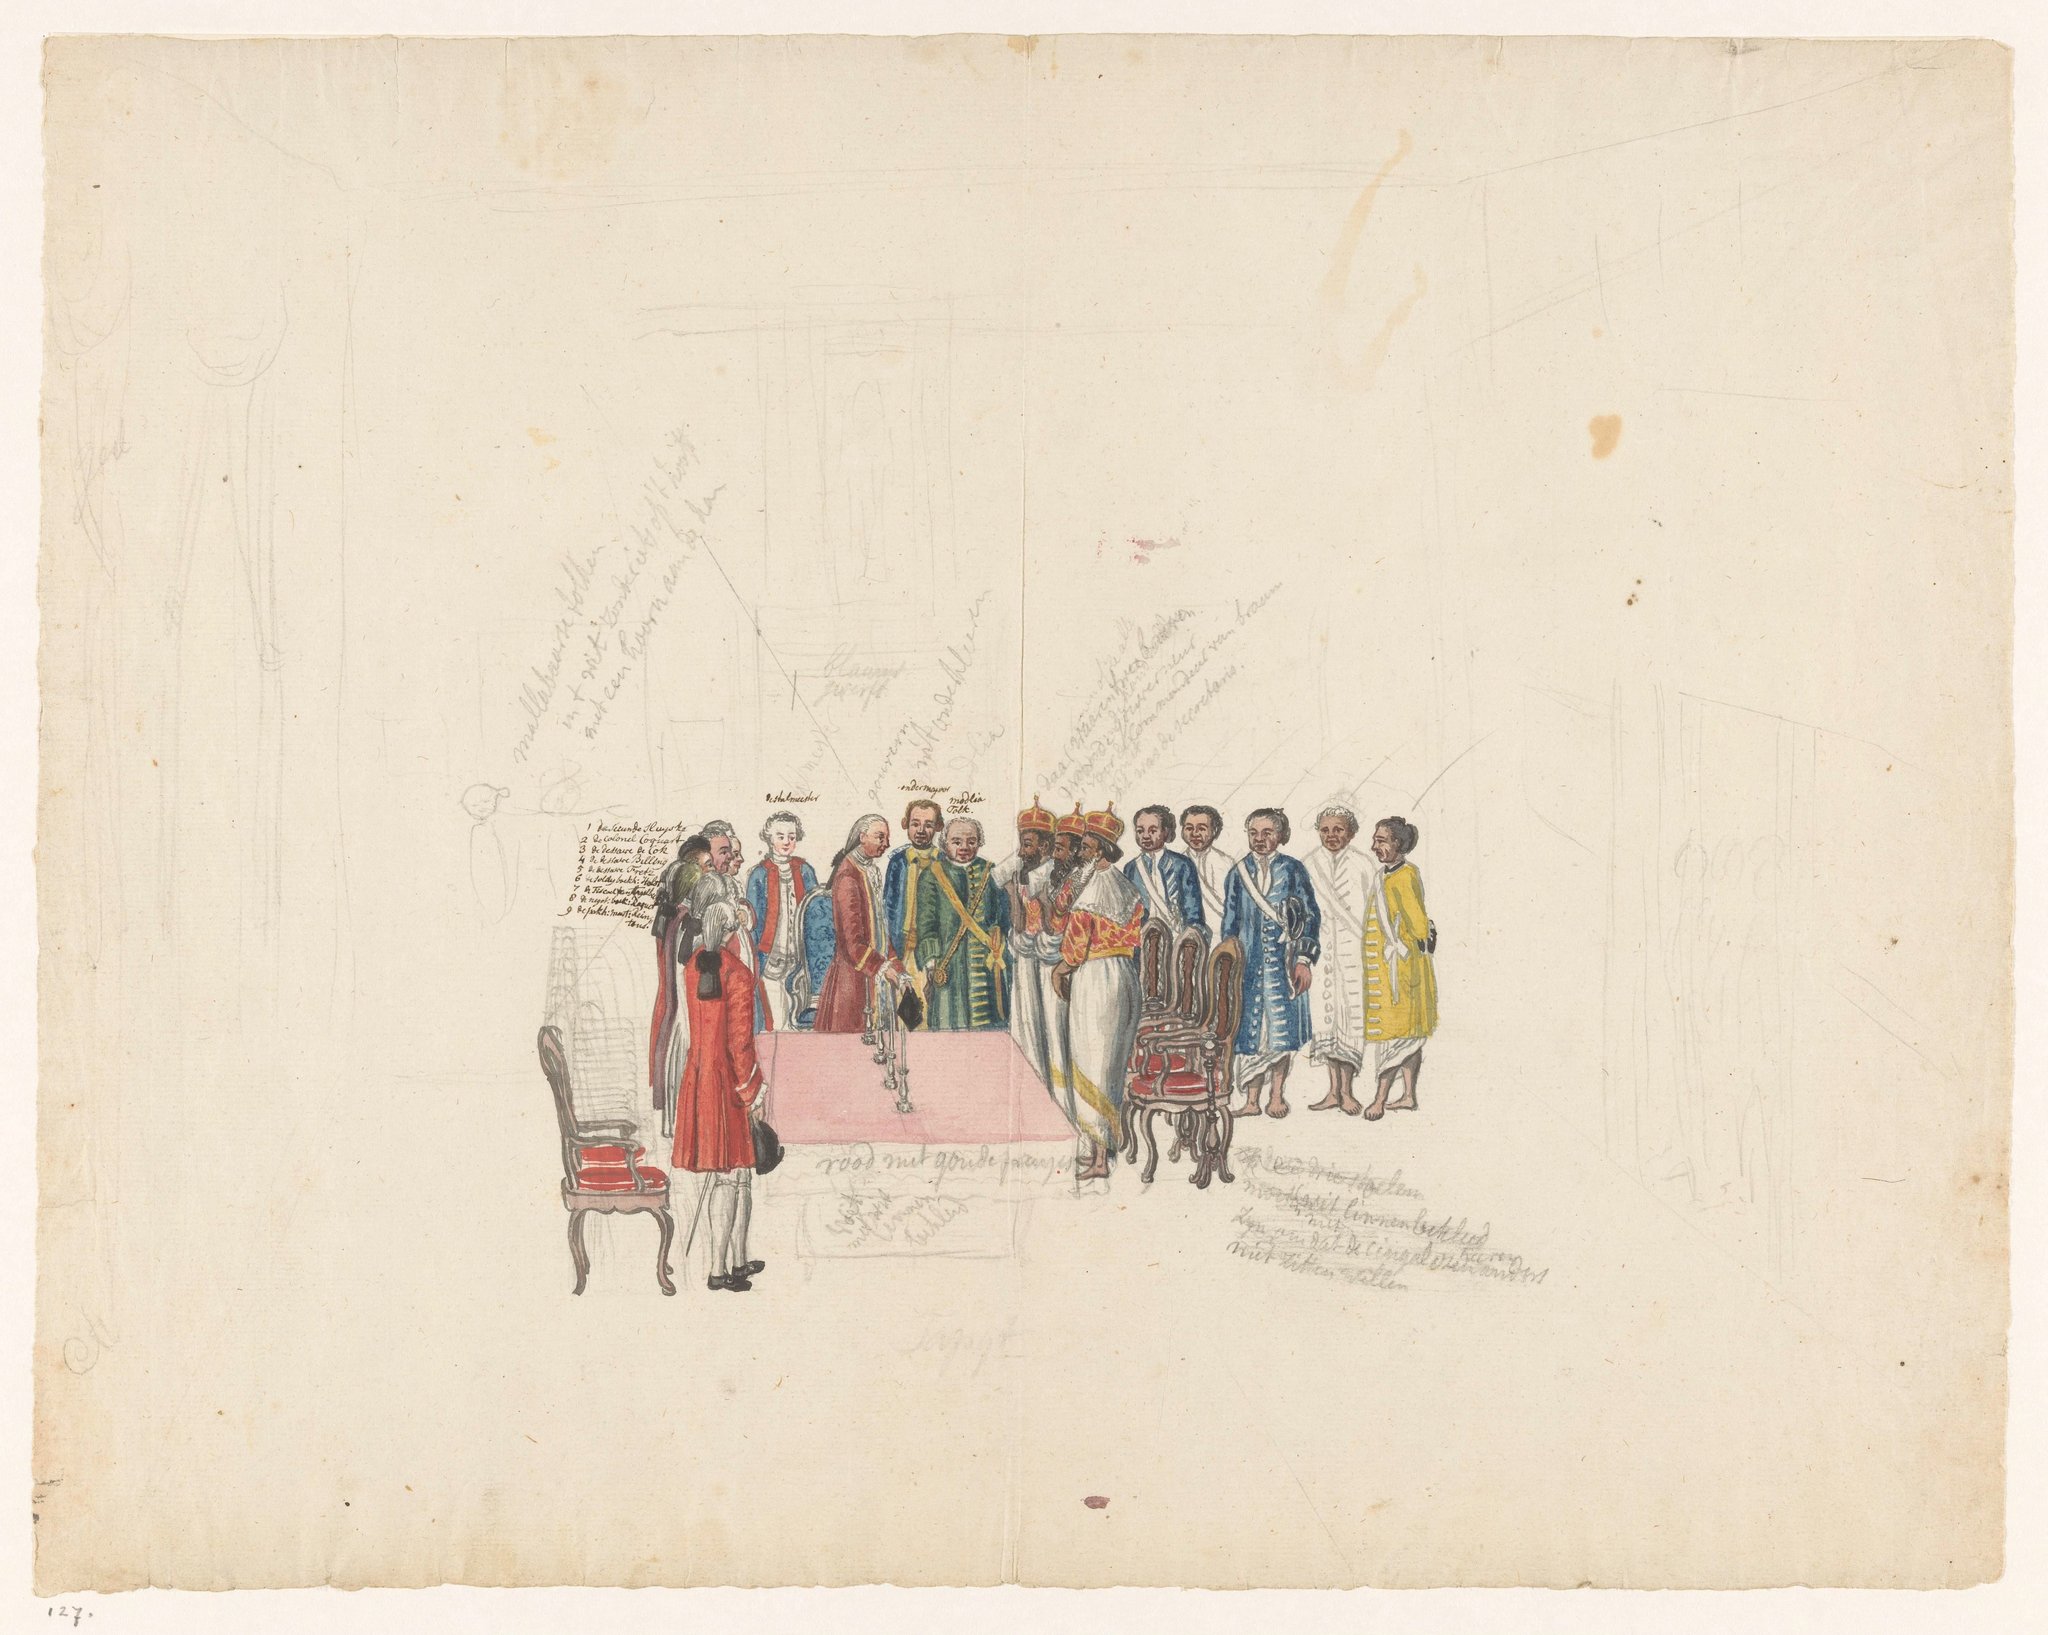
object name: drawing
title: Ontvangst van de gezanten van de koning van Kandy, 1785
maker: jan brandes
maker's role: draughtsman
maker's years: 1743-1808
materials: paper, pencil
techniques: brush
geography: colombo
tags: asiatic races and peoples (srilankans), audition; ruler giving audience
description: Ontvangst in november 1785 van het gezantschap van Kandy door gouverneur Van de Graaff en een gezelschap hoge VOC-beambten met centraal de modlia of tolk Nicolas Dias Abayasinha Amarasekera. De ontvangstruimte is in potlood geschetst. De opschriften verwijzen naar de voorgestelde personen. Onderdeel uit het schetsboek van Jan Brandes, dl. 1 (1808), p. 13 [militairen in dienst van de koning van Kandy].